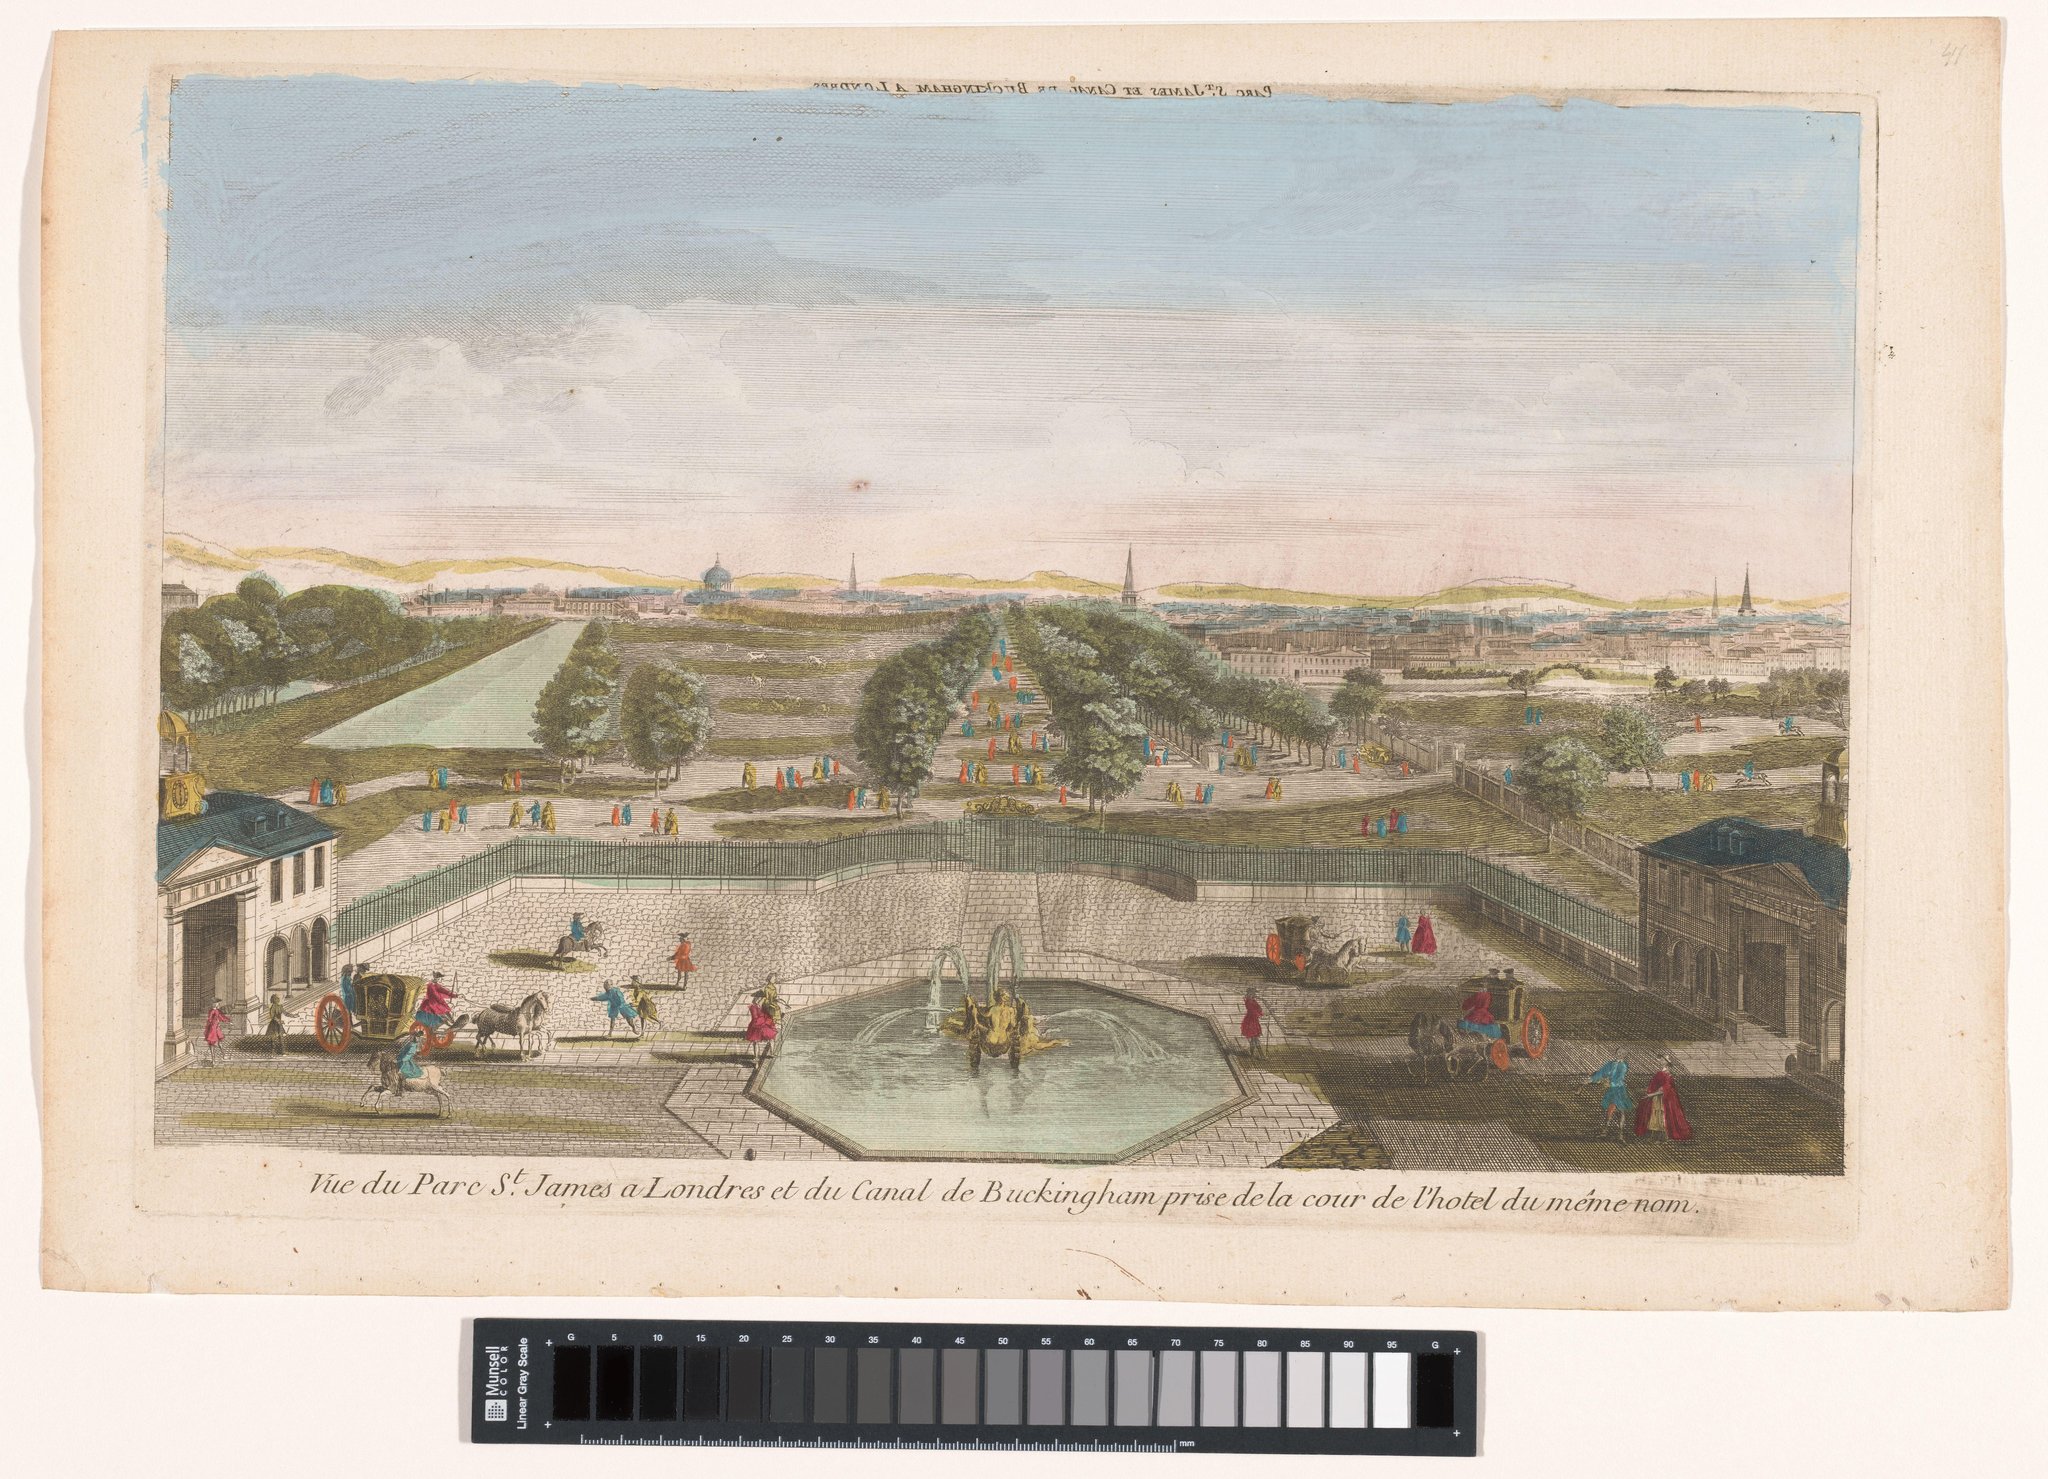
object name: opticaprent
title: Parc St. James et canal de Buckingham a Londres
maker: Anonymous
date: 1700-1799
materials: paper, watercolor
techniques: brush, etching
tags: public gardens, park (+ city(-scape) with figures, staffage), avenue, boulevard, promenade, esplanade (+ city(-scape) with figures, staffage), canal, palace, church (exterior)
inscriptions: collector's mark: Lugt 2166, watermark:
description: Links het kanaal en in het midden The Mall. Op de achtergrond Saint Paul's Cathedral.